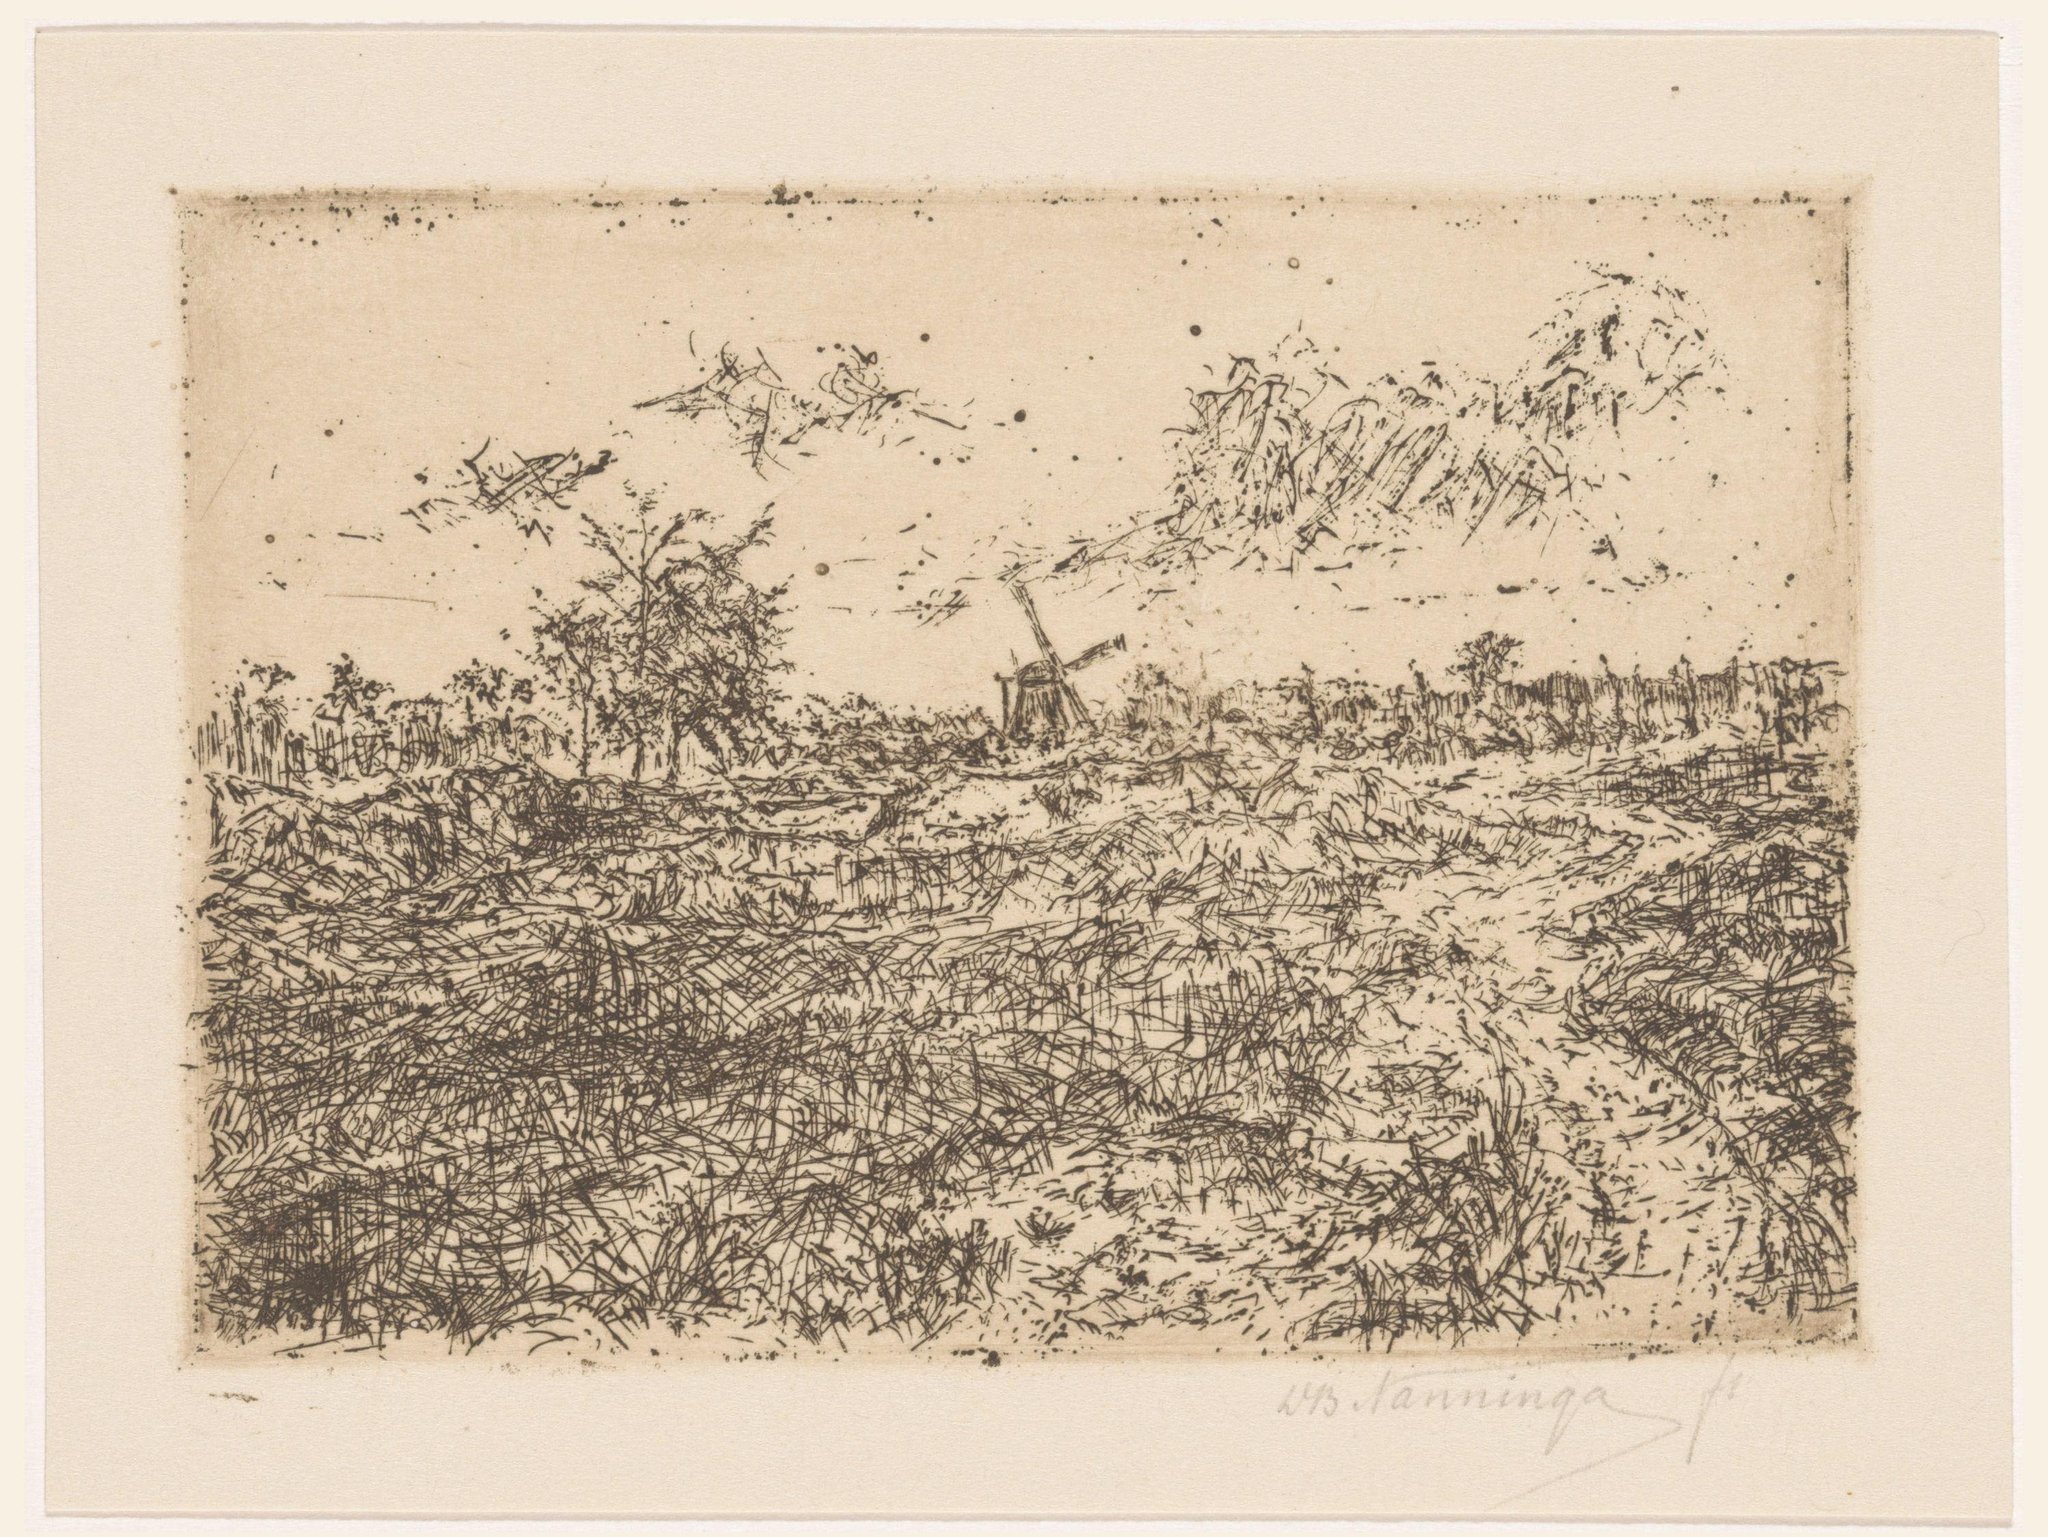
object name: print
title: Landschap met molen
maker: dirk berend nanninga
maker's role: print maker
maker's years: 1868-1954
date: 1878-1931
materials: paper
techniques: etching, intaglio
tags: windmill in landscape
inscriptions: collector's mark: Lugt 2228